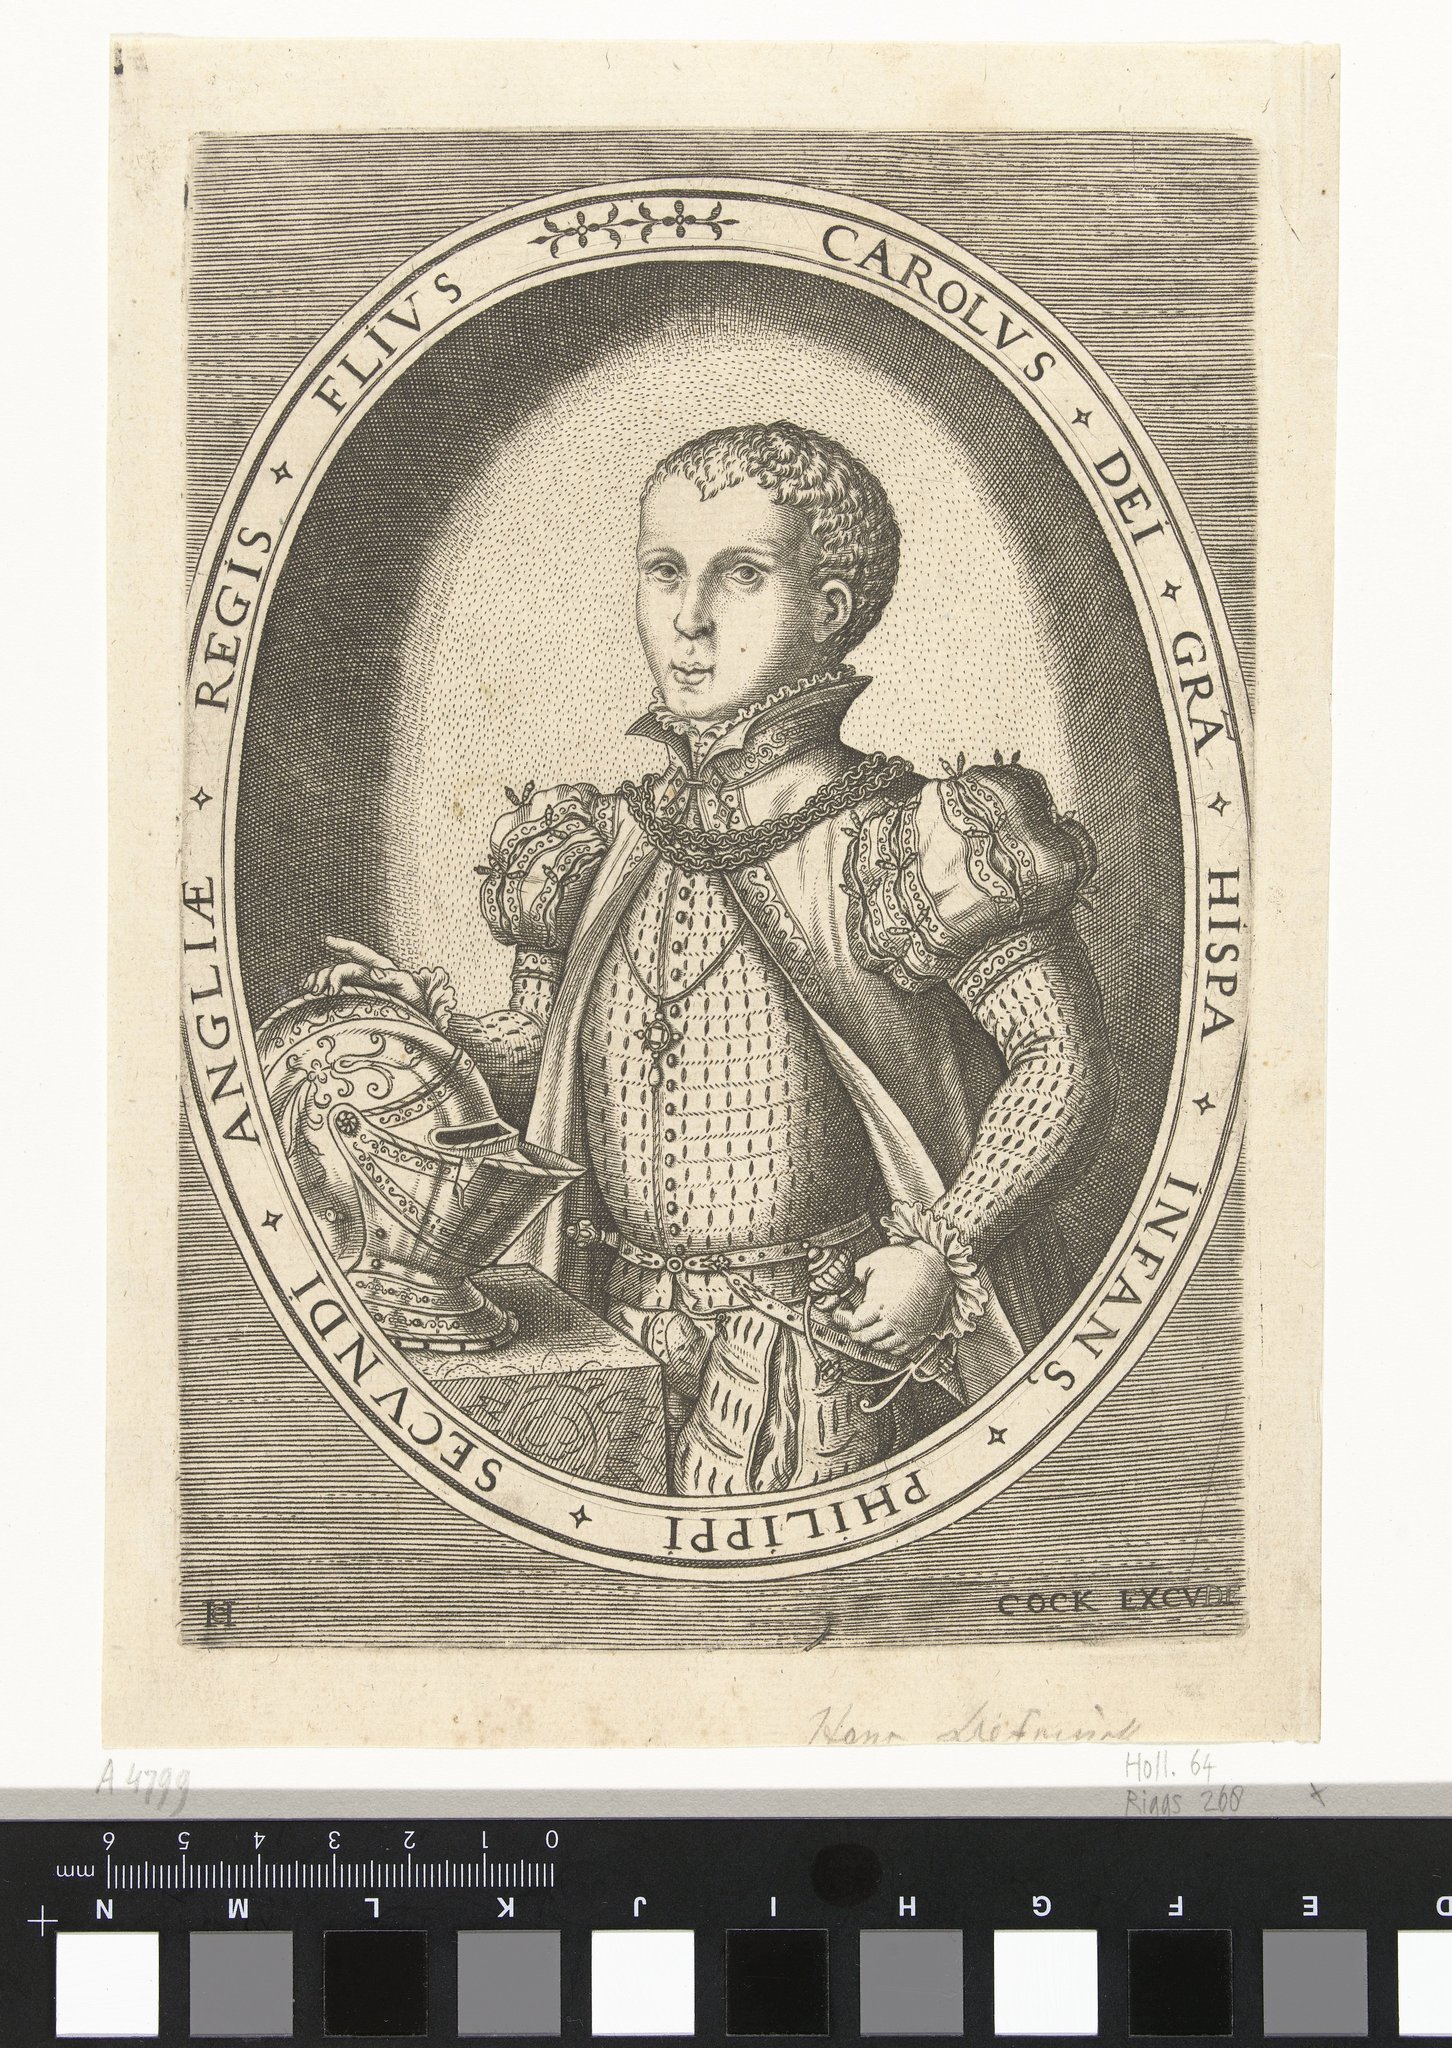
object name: print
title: Portret van prins Don Carlos van Spanje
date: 1554-1556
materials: paper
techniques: engraving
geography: antwerp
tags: carlos van spanje (prins)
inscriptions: collector's mark: Lugt 2228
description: Portret van prins Don Carlos van Spanje, de eerste zoon van Filips II van Spanje. Buste naar links, in ovaal met randschrift.